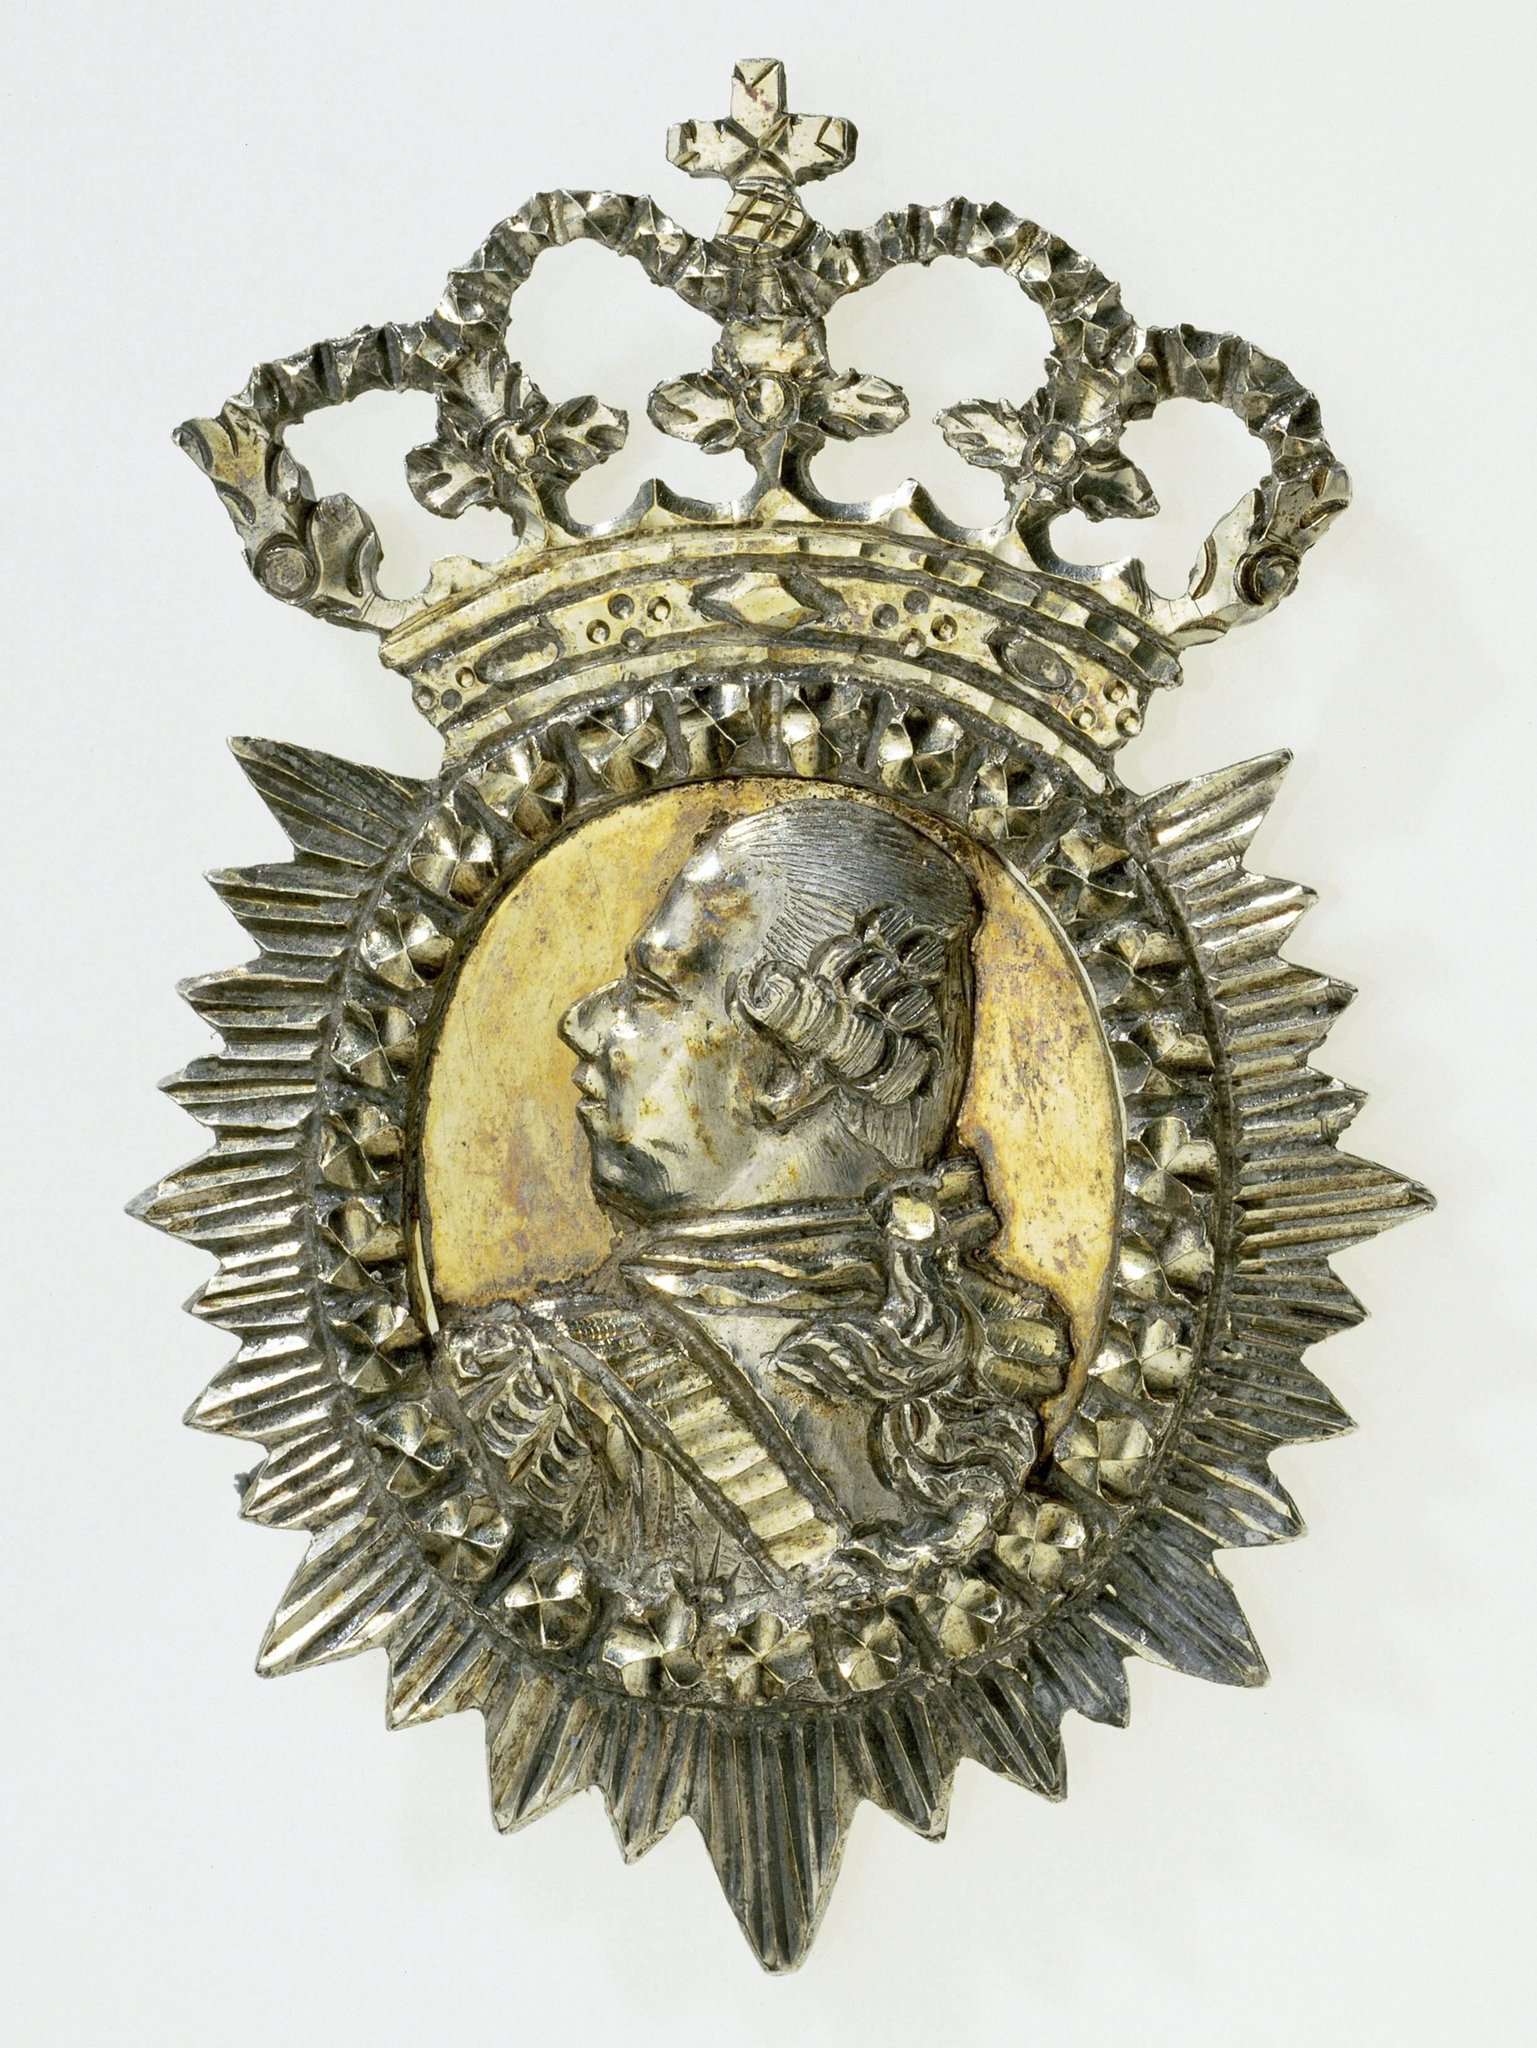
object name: insignia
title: Willem V en Wilhelmina van Pruisen, prins en prinses van Oranje-Nassau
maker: Anonymous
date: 1787-1795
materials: silk, silver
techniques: embroidery, soldering, weave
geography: netherlands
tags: the hague, william v (prince of orange), berlin, painter, draughtsman, wilhelmina of prussia (princess of orange), historical persons - bb - woman, historical persons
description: Badges with portraits of Stadholder William V and his wife Wilhelmina of Prussia, c. 1780-1795.